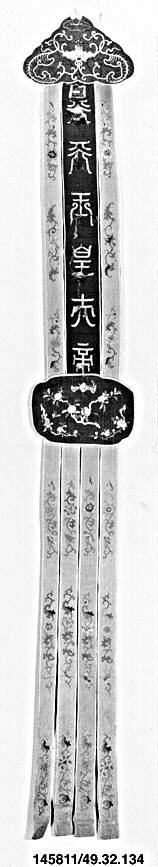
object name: hanging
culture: chinese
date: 1736-1795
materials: metal thread, silk